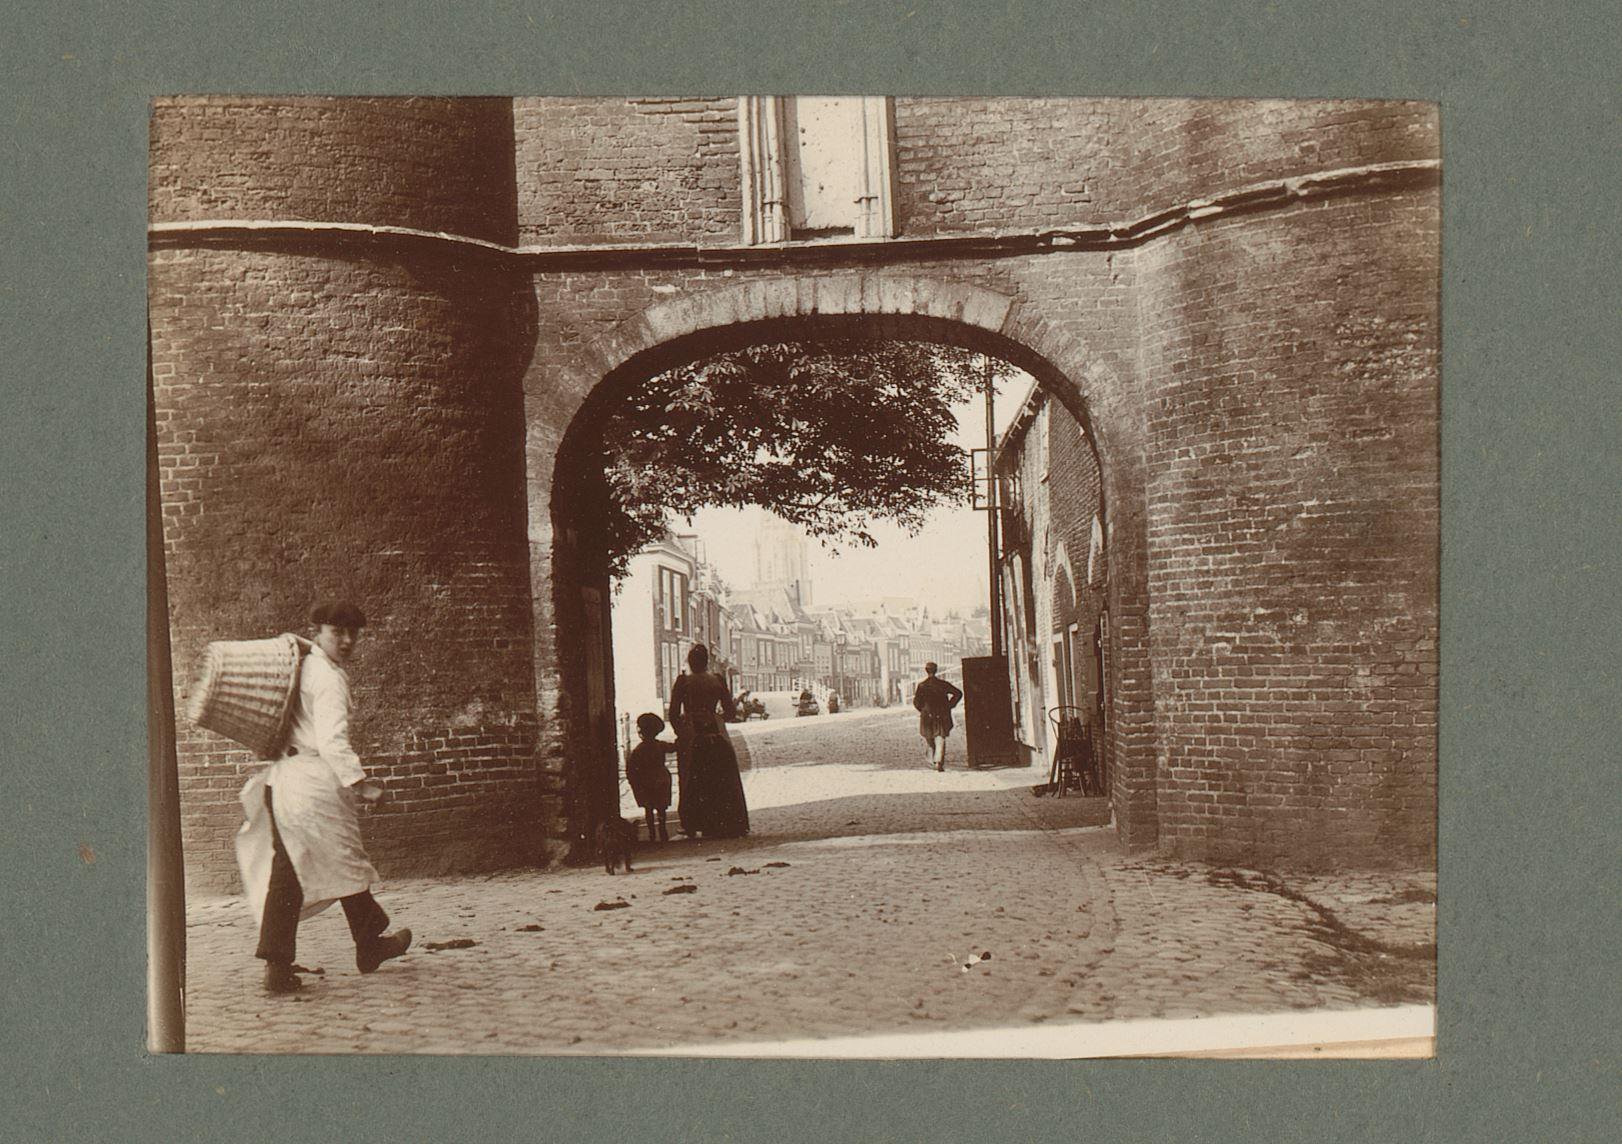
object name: photograph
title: Gezicht op de Oostpoort te Delft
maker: george hidderley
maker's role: fotograaf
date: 1900-1920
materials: photographic support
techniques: gelatin silver print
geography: delft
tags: city-walls, street, parts of church exterior and annexes: tower